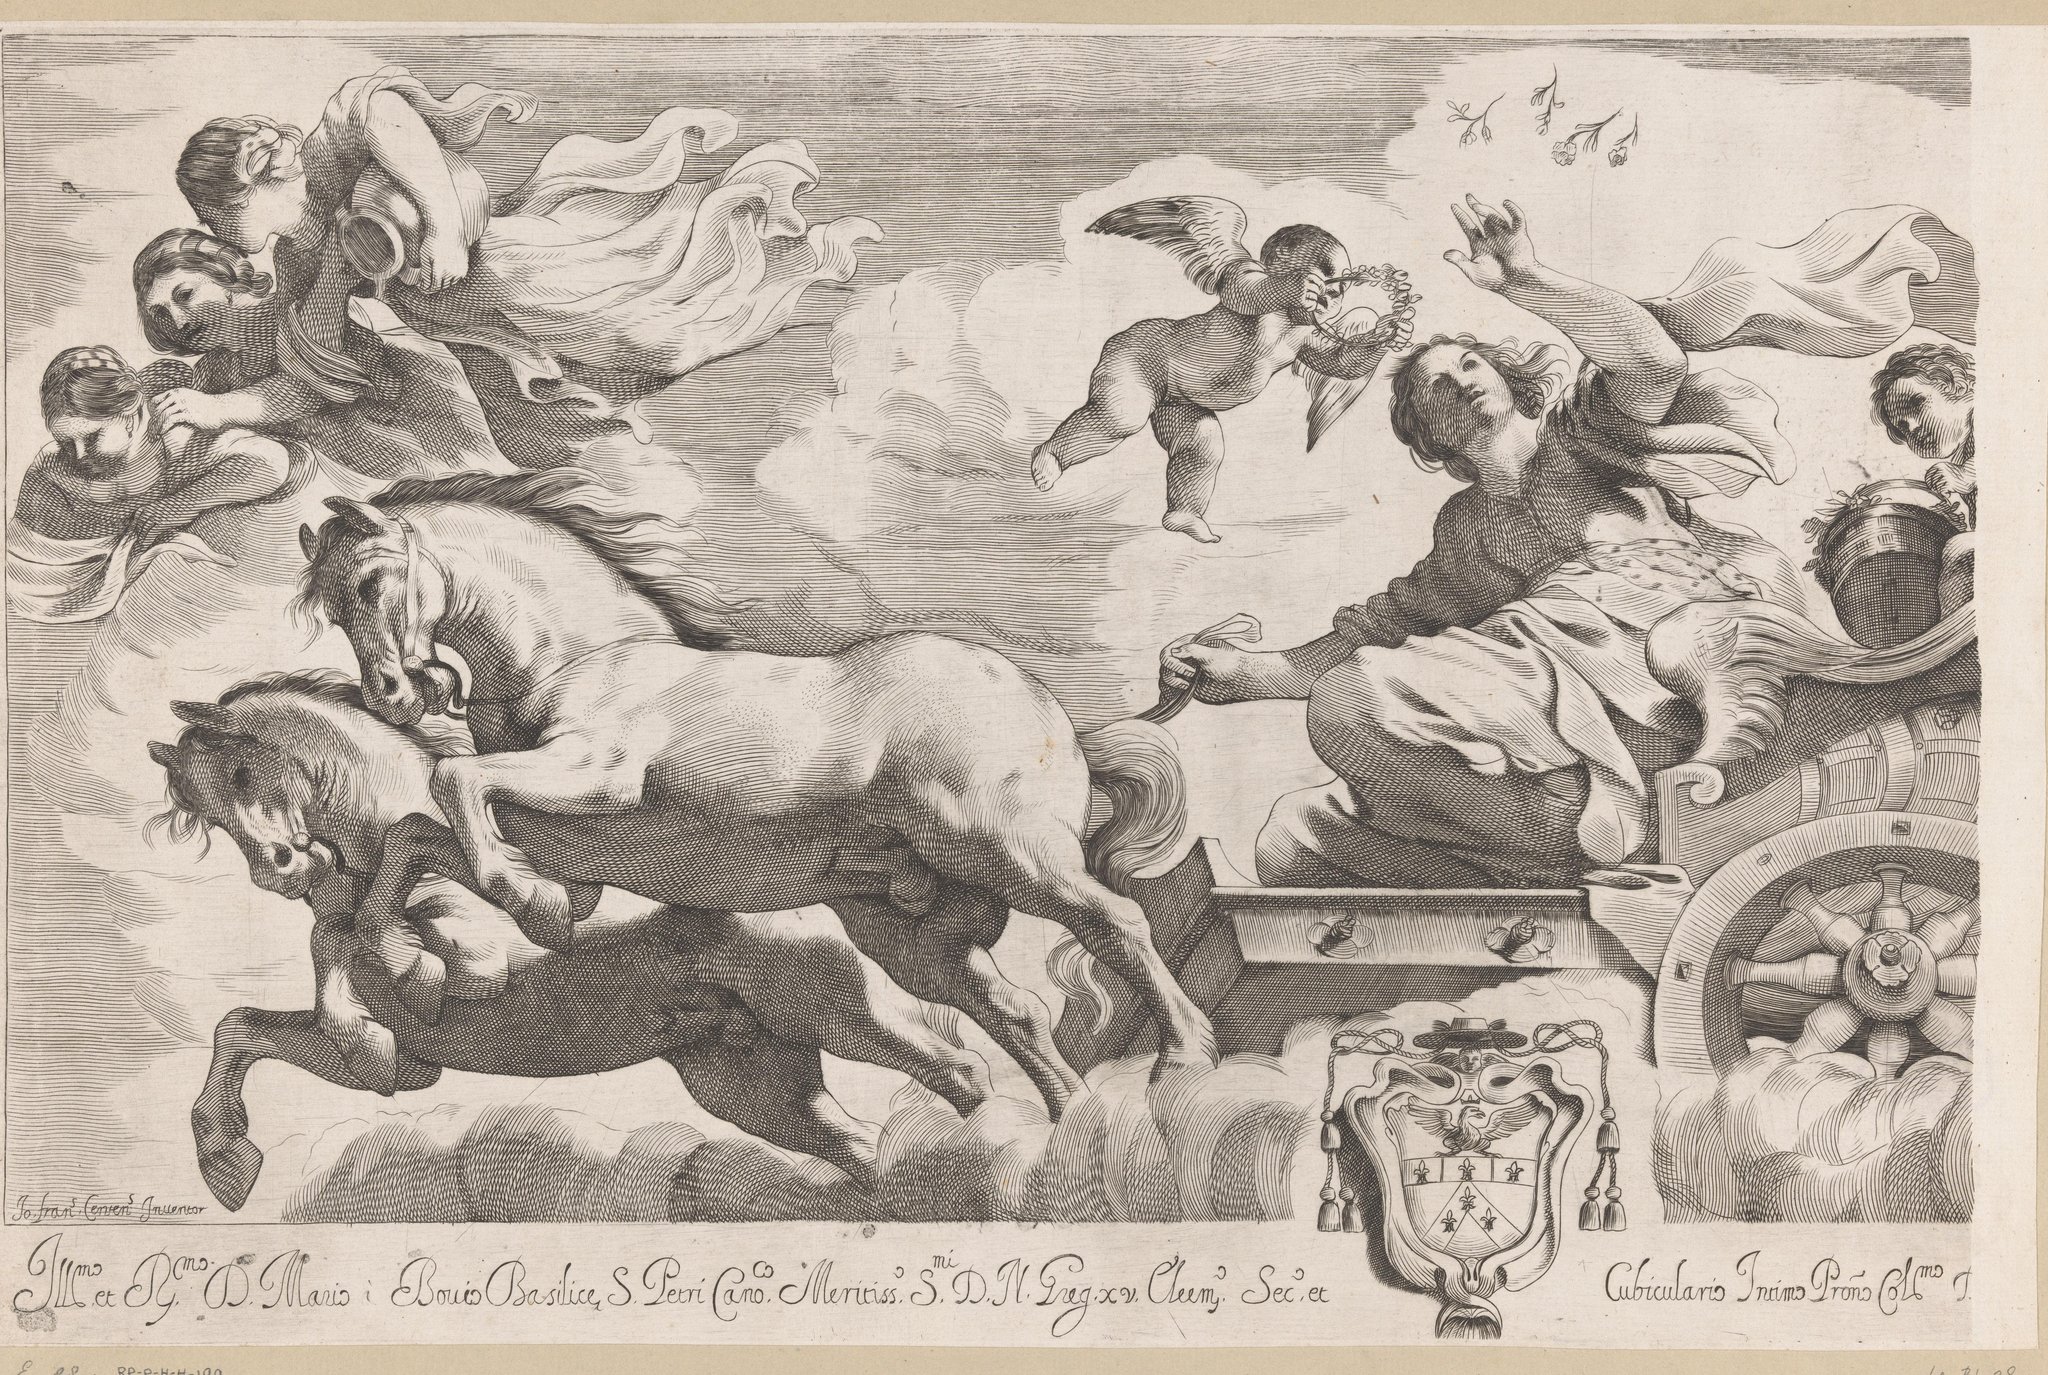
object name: print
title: Aurora verjaagt de nacht (linkerdeel)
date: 1621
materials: paper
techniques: engraving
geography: rome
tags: triumph of aurora: in her chariot drawn by two (sometimes four) horses, and possibly scattering flowers; aurora's victory over the night; 'carro dell'aurora' (ripa), hours (horae), seasons, armorial bearing, heraldry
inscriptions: collector's mark: Lugt 11, collector's mark: Lugt 10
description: Strooiend met bloemen rijdt Aurora op haar wagen die wordt getrokken door twee paarden. Iedere morgen verjaagt Aurora de nacht en brengt zij het ochtendgloren. Voor haar uit zweven de Horae, de godinnen van de jaargetijden. Rechts kijkt Aurora's echtgenoot Tithonus haar na. Opdracht in de ondermarge en middenonder een wapenschild.